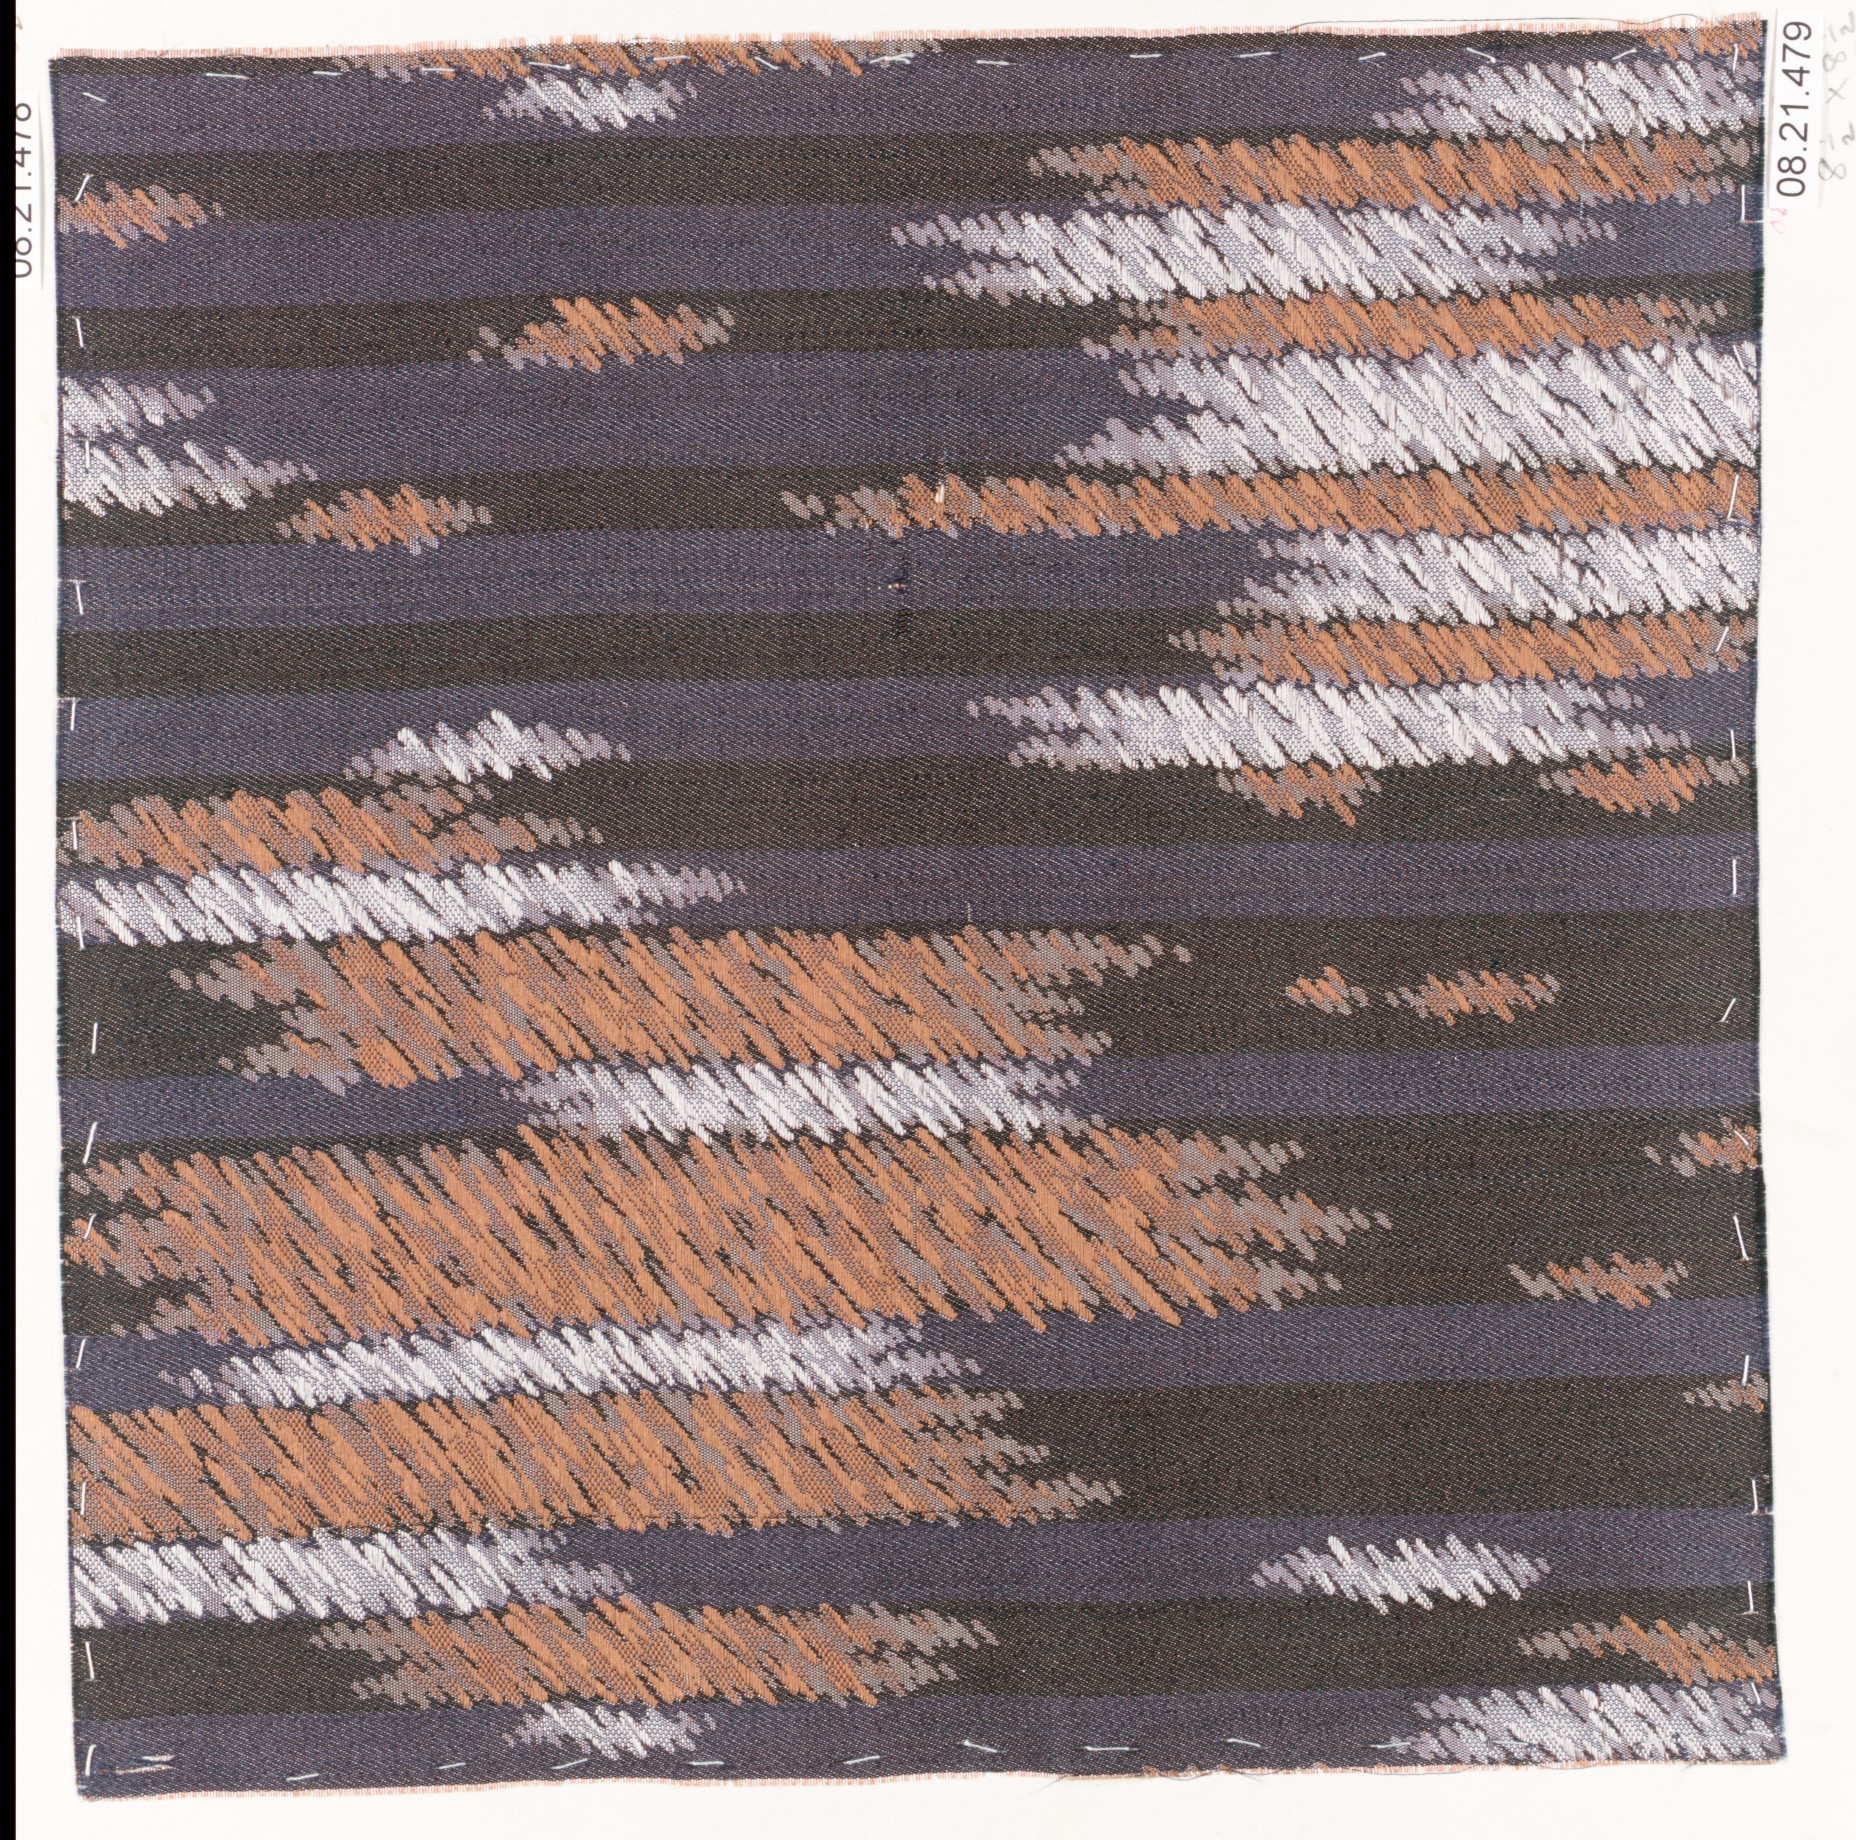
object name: textile sample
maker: Anonymous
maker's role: designer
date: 1900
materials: silk